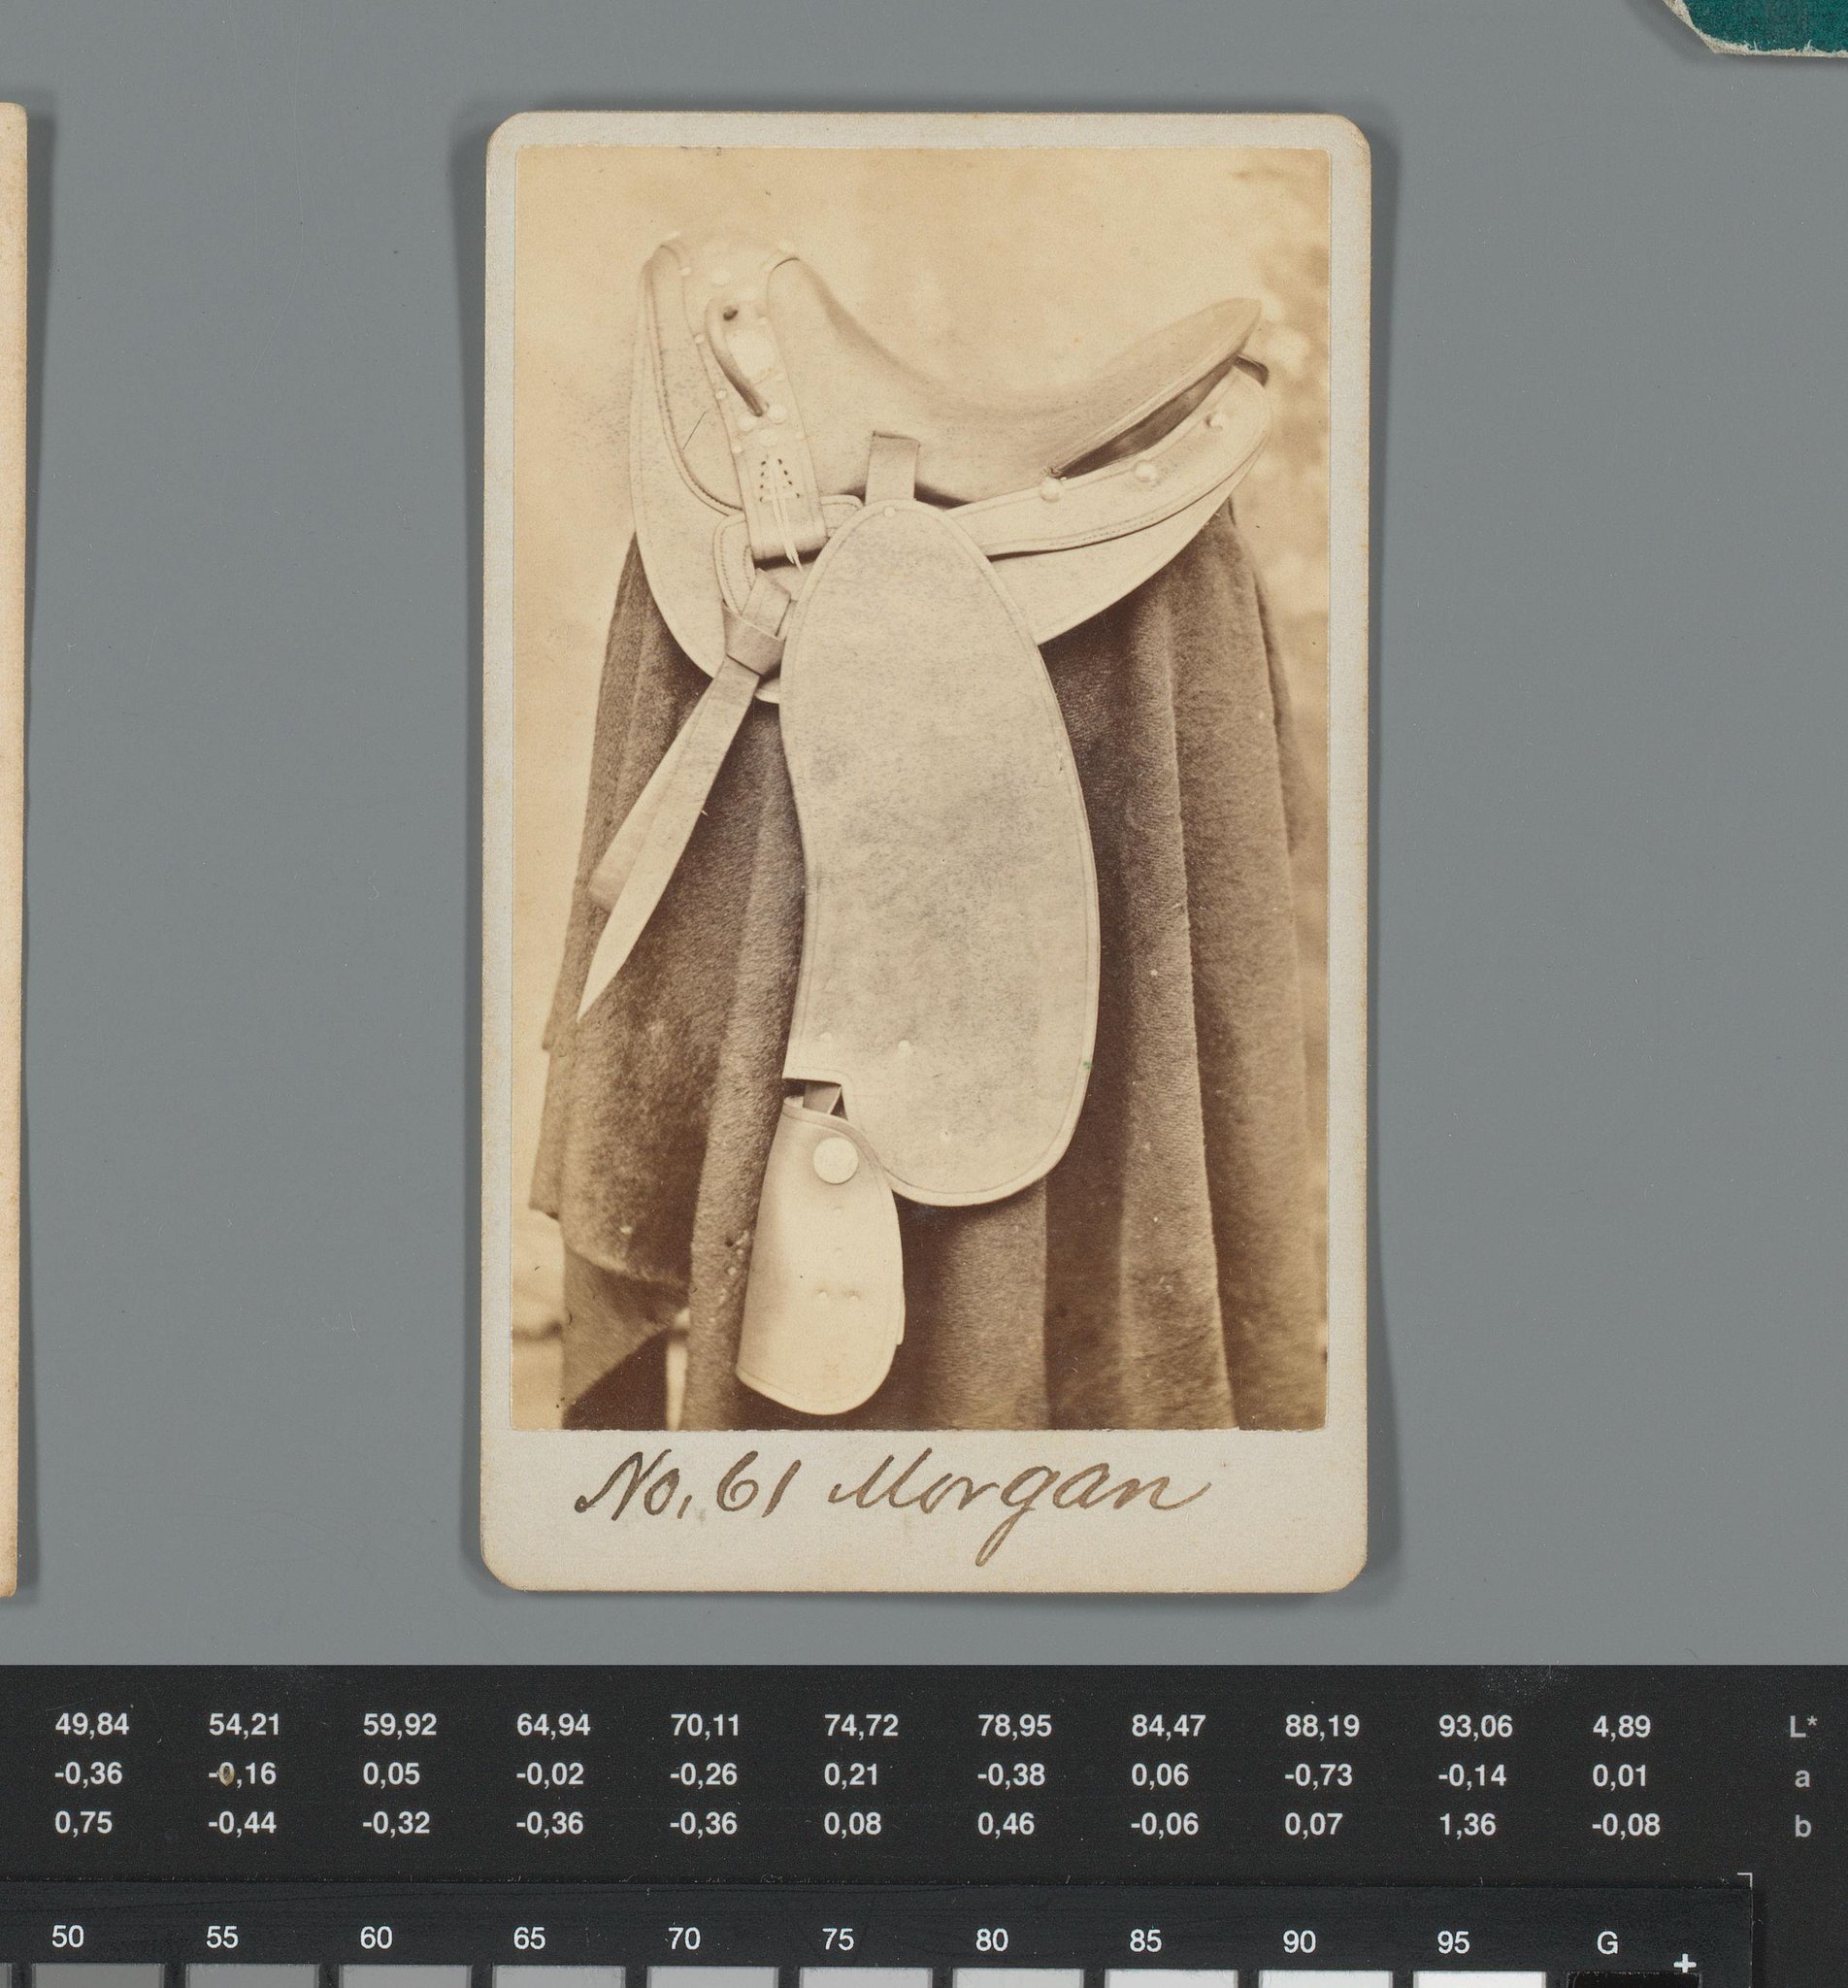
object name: photograph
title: No. 61 Ungan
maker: Anonymous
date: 1850-1915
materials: cardboard, photographic support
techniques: albumen print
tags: advertising, saddle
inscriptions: inscription: ‘Unjan saddle’